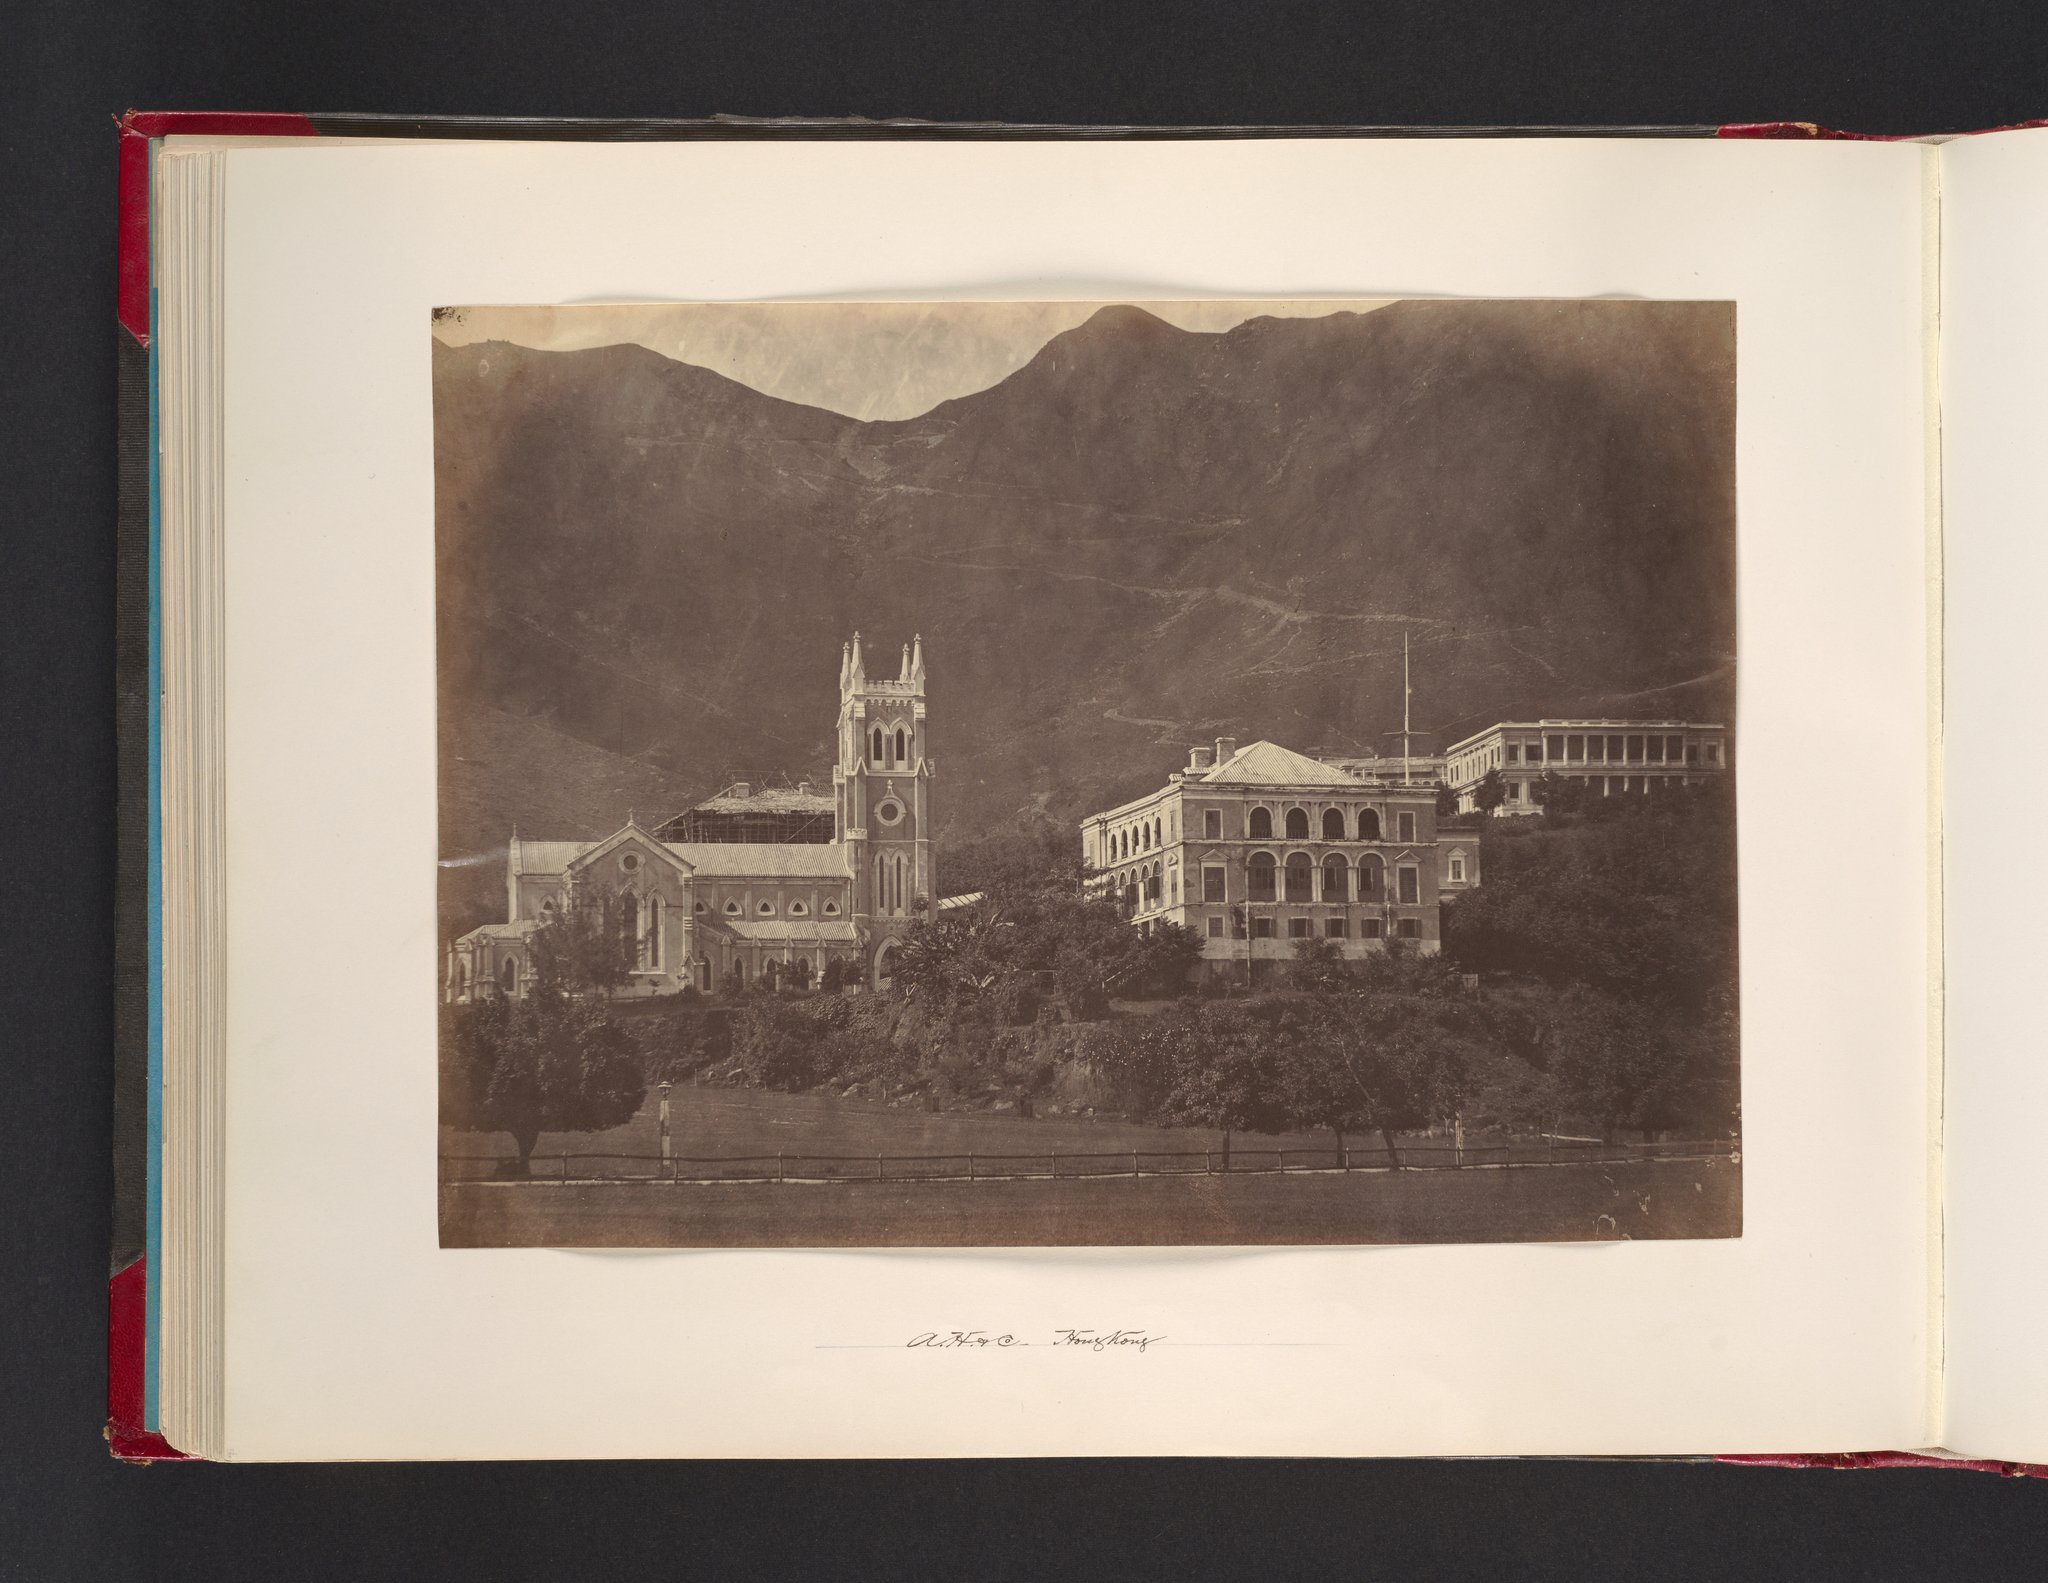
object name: photograph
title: Augustine Heard & Co., Hong Kong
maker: john thomson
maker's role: artist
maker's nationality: british, scottish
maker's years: 1837-1921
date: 1865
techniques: albumen silver print, glass negative